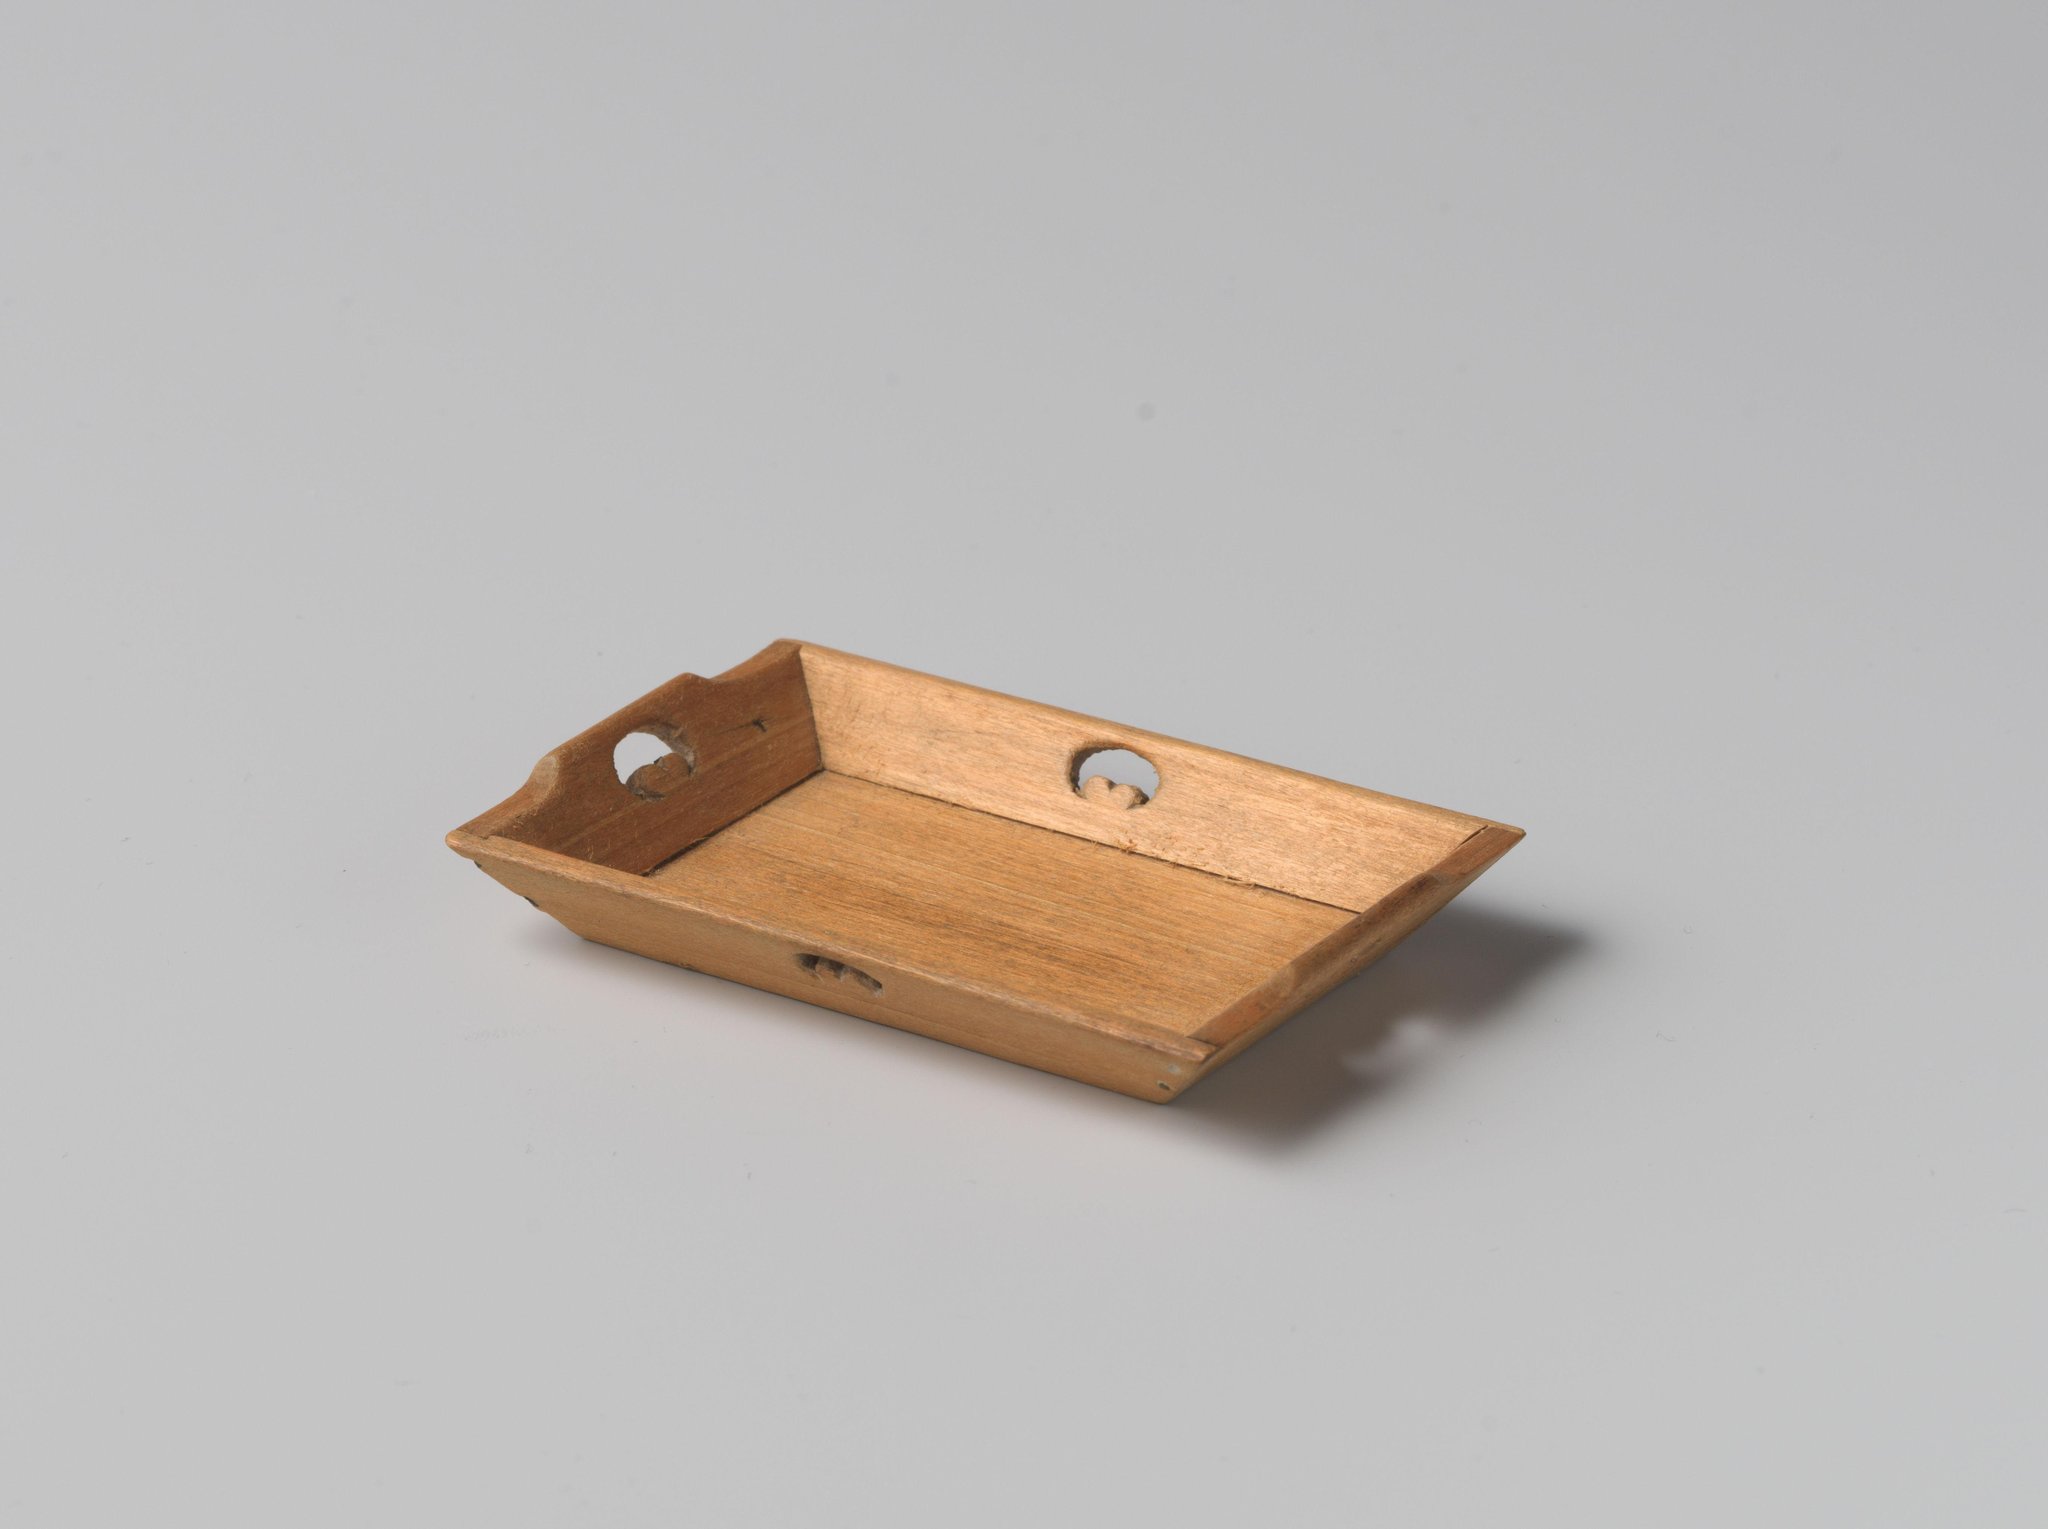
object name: miniature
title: Kleerbak met vier schuin opstaande wanden, waarin een handgreep is uitgezaagd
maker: Anonymous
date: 1690-1710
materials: brass, wood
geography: amsterdam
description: Kleerbak van without met vier schuin opstaande wanden, waarin een maanvormige handgreep is uitgezaagd. De wanden en de bodem zijn met nagels aan elkaar verankerd. De bak is licht ingewreven met witte verf.